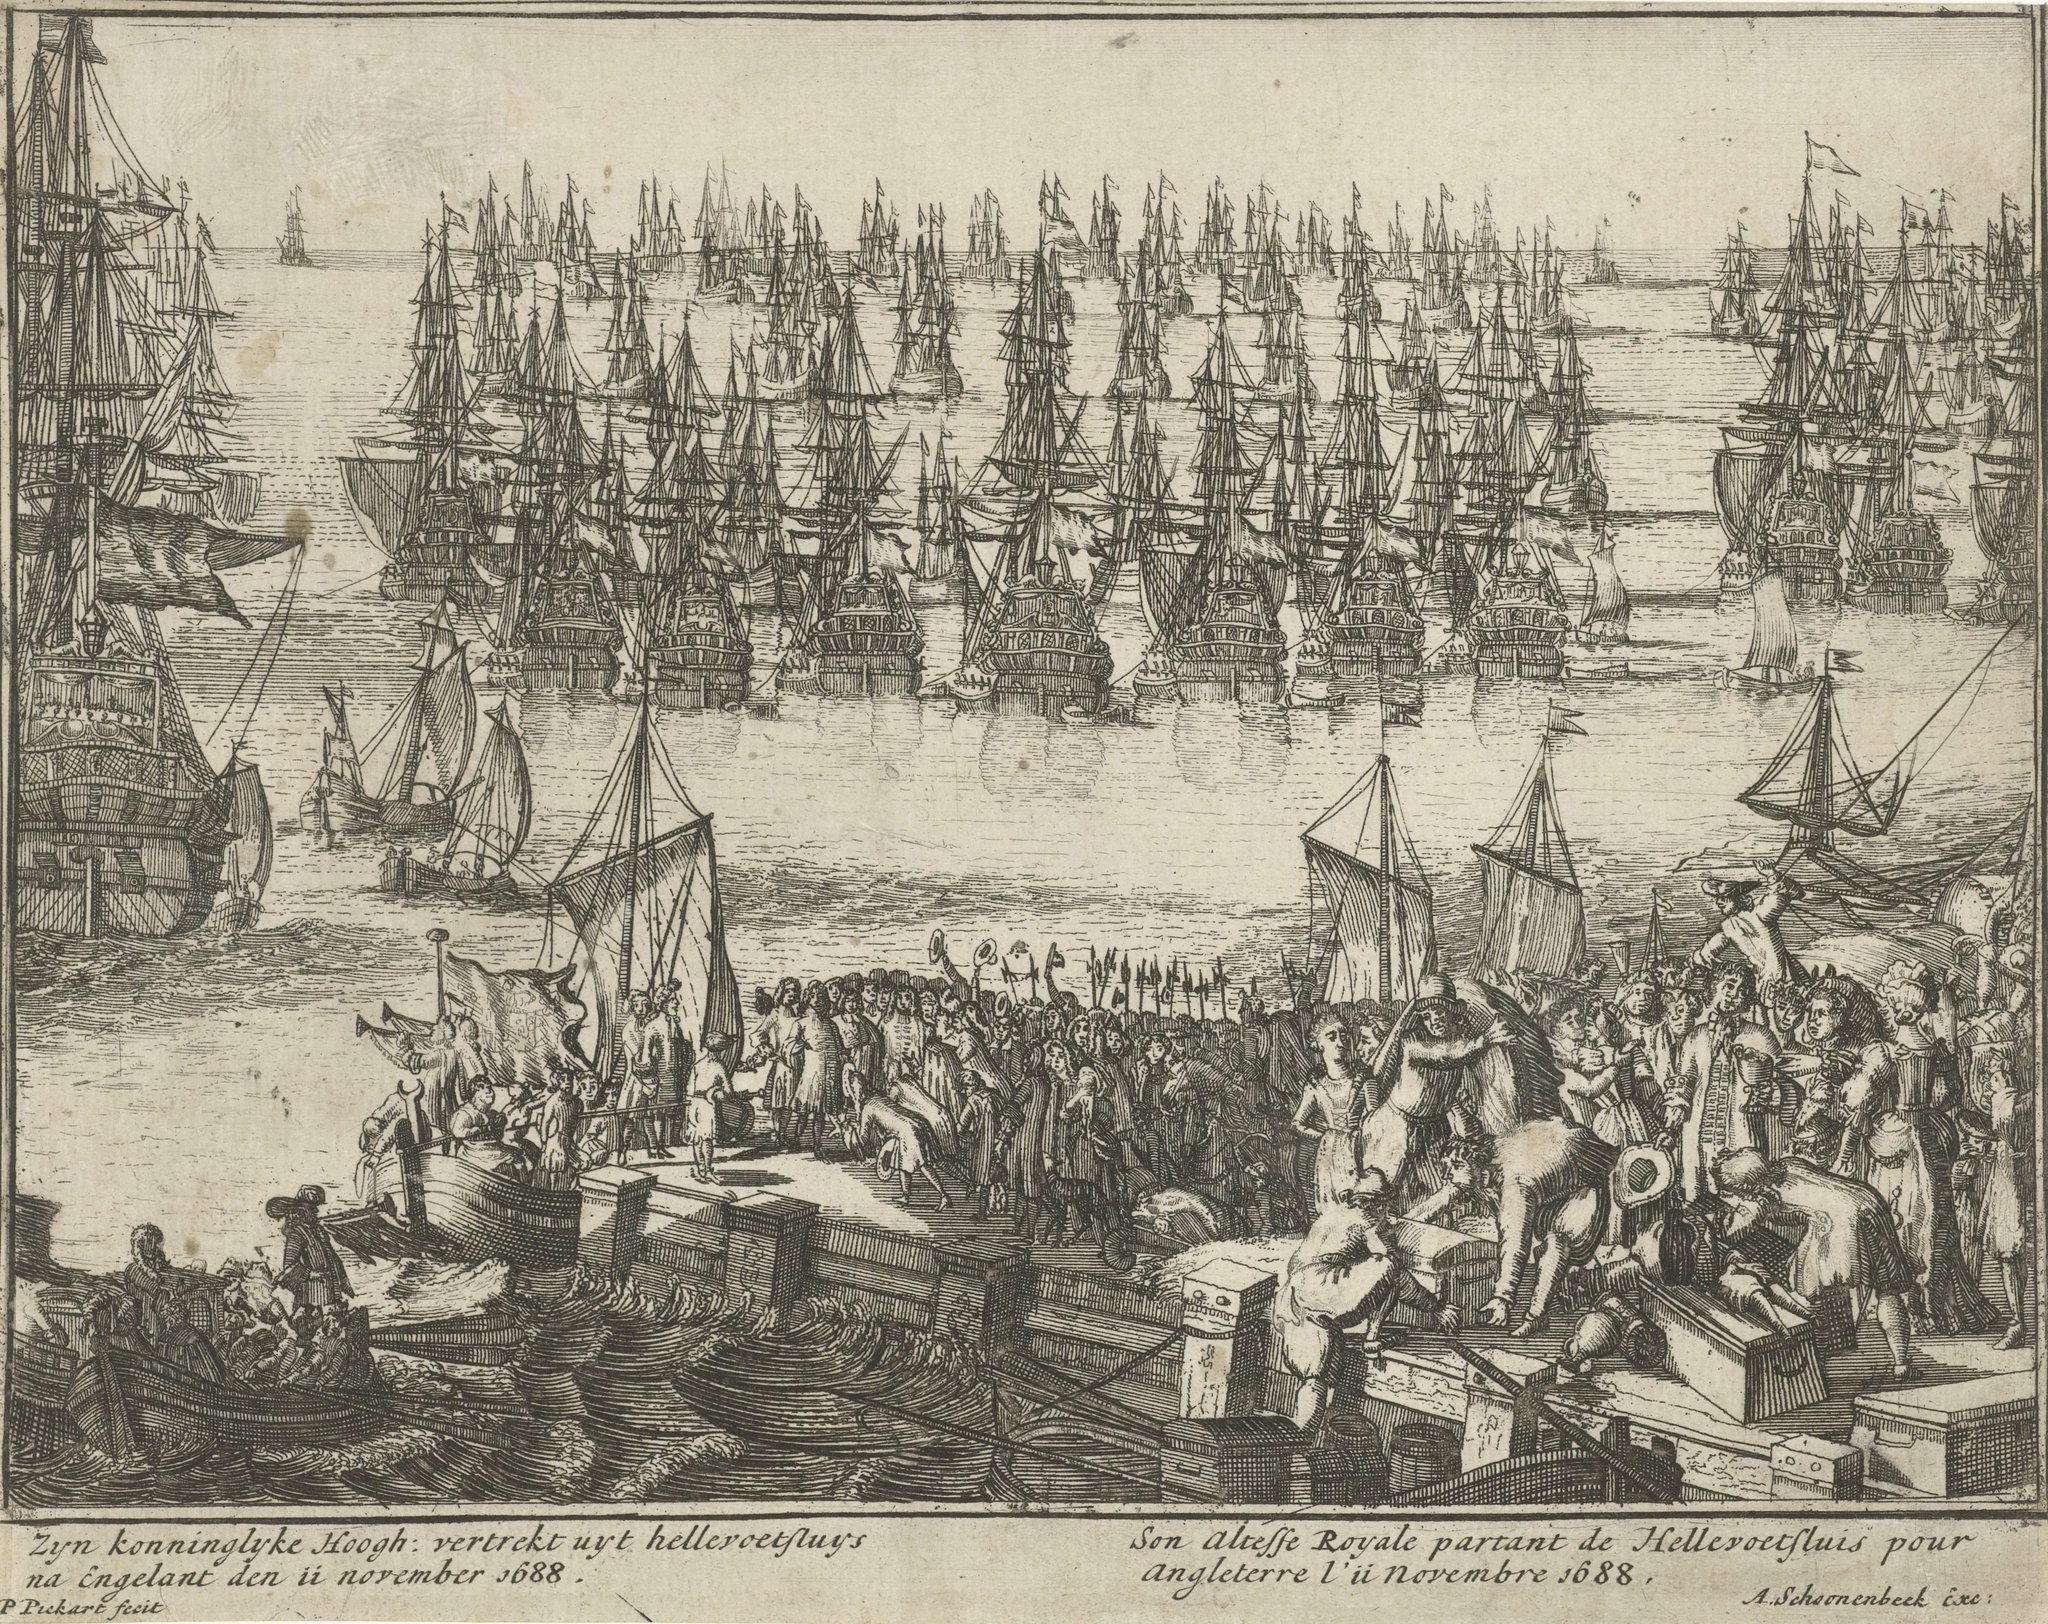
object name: print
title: Zyn konninglyke Hoogh: vertrekt uyt hellevoetsluys na Engelant den 11 november 1688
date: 1689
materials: paper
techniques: etching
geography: amsterdam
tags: the hague, william iii (prince of orange and king of england, scotland, and ireland), departure ~ travelling, hellevoetsluis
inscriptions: collector's mark: Lugt 2760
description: Prins Willem III vertrekt met de vloot vanuit Hellevoetsluis naar Engeland, 11 november 1688. De prins neemt op de pier afscheid. Onderdeel van de serie 'Engelants schouwtoneel' over de Glorious Revolution 1688-1689 (tweede deel). Met onderschriften in het Nederlands en Frans.